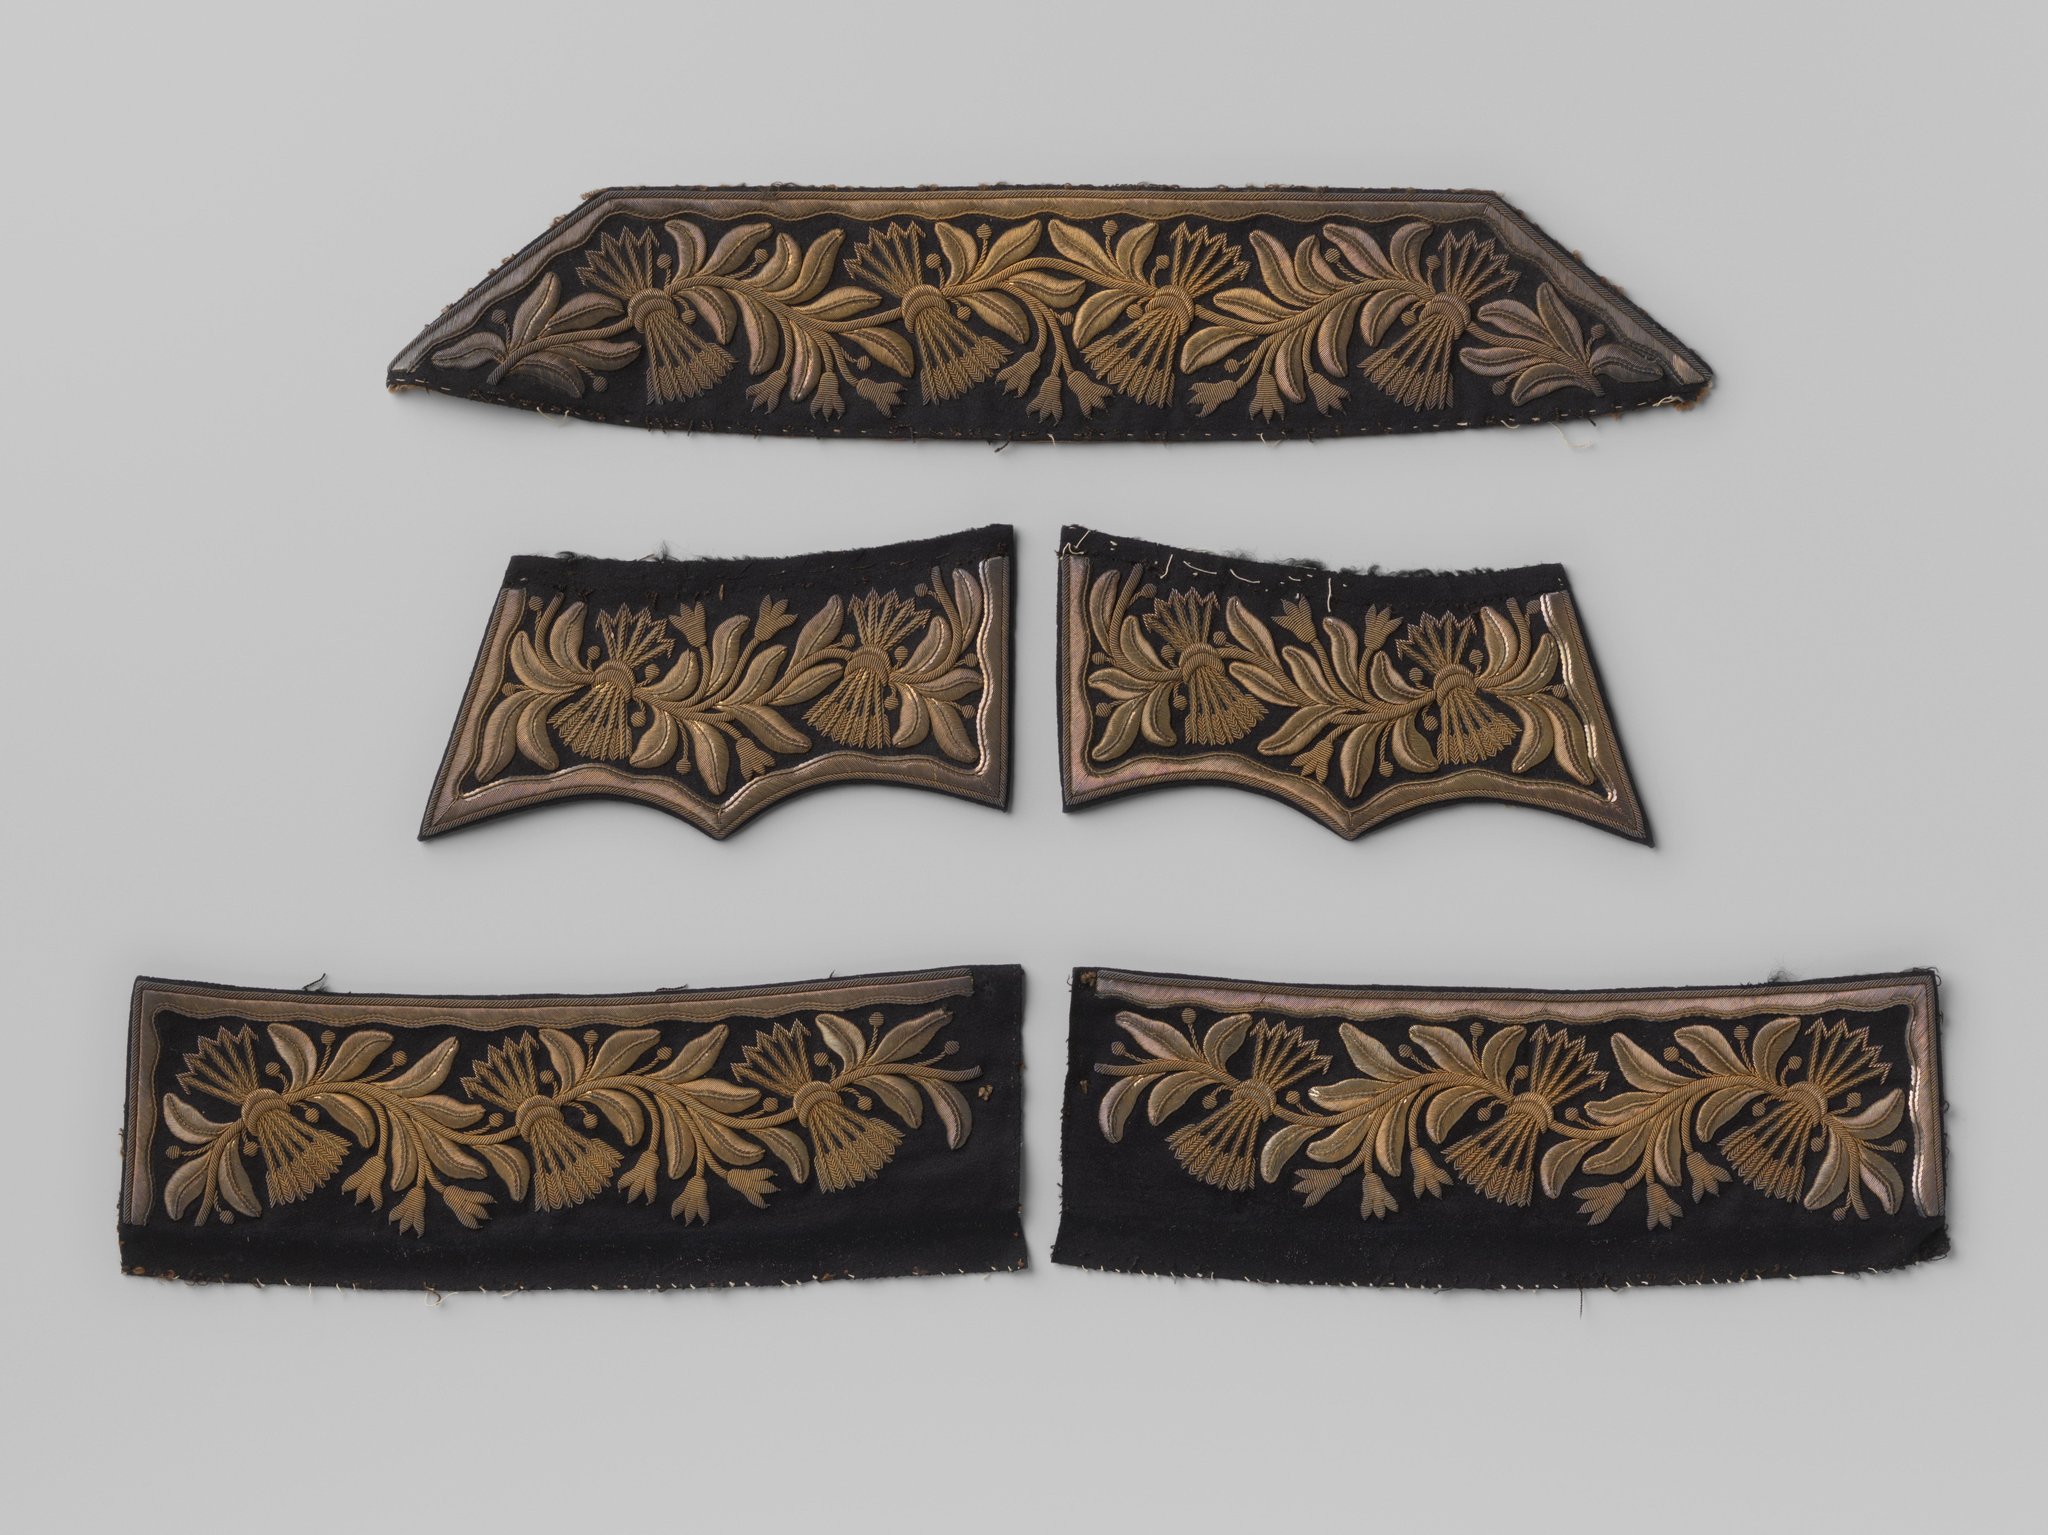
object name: embroidery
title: Borduursel voor jas van J.R. Thorbecke (boord)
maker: Anonymous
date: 1850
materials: textile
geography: netherlands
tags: the hague, johan rudolf thorbecke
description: Borduursel voor jas behorende bij ambtskostuum van J.R. Thorbecke als minister van Binnenlandse Zaken.